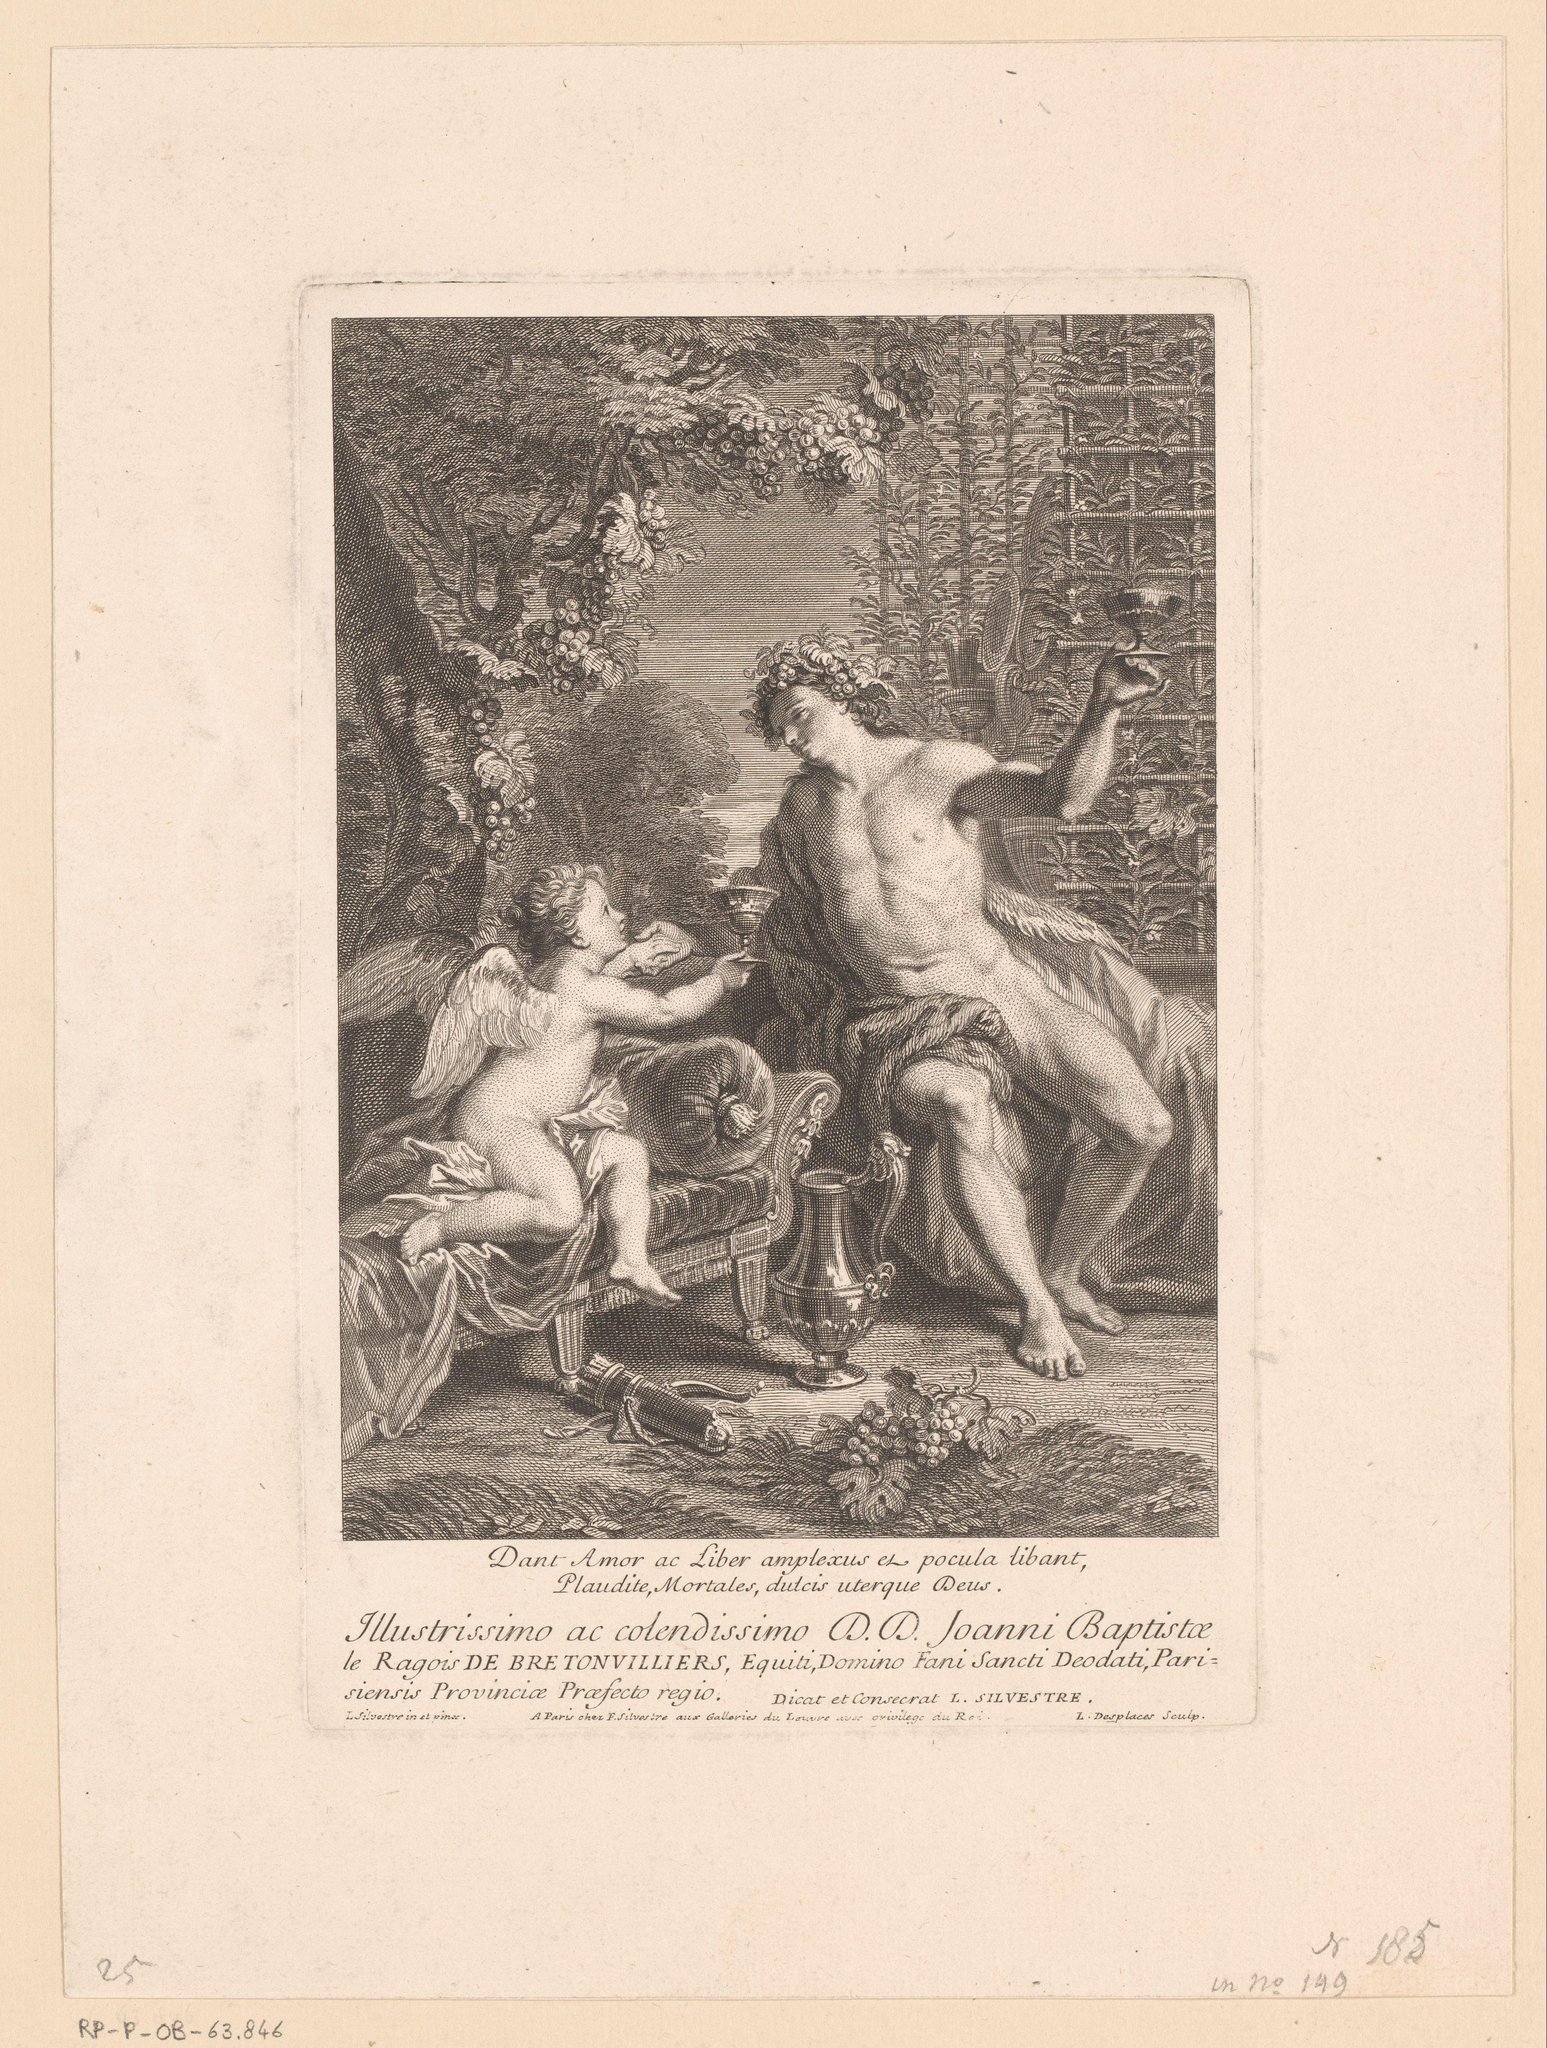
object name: print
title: Bacchus en Amor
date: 1692-1738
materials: paper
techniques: engraving, etching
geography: paris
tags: (story of) bacchus (dionysus), liber, (story of) cupid, amor (eros)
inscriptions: collector's mark: Lugt 240